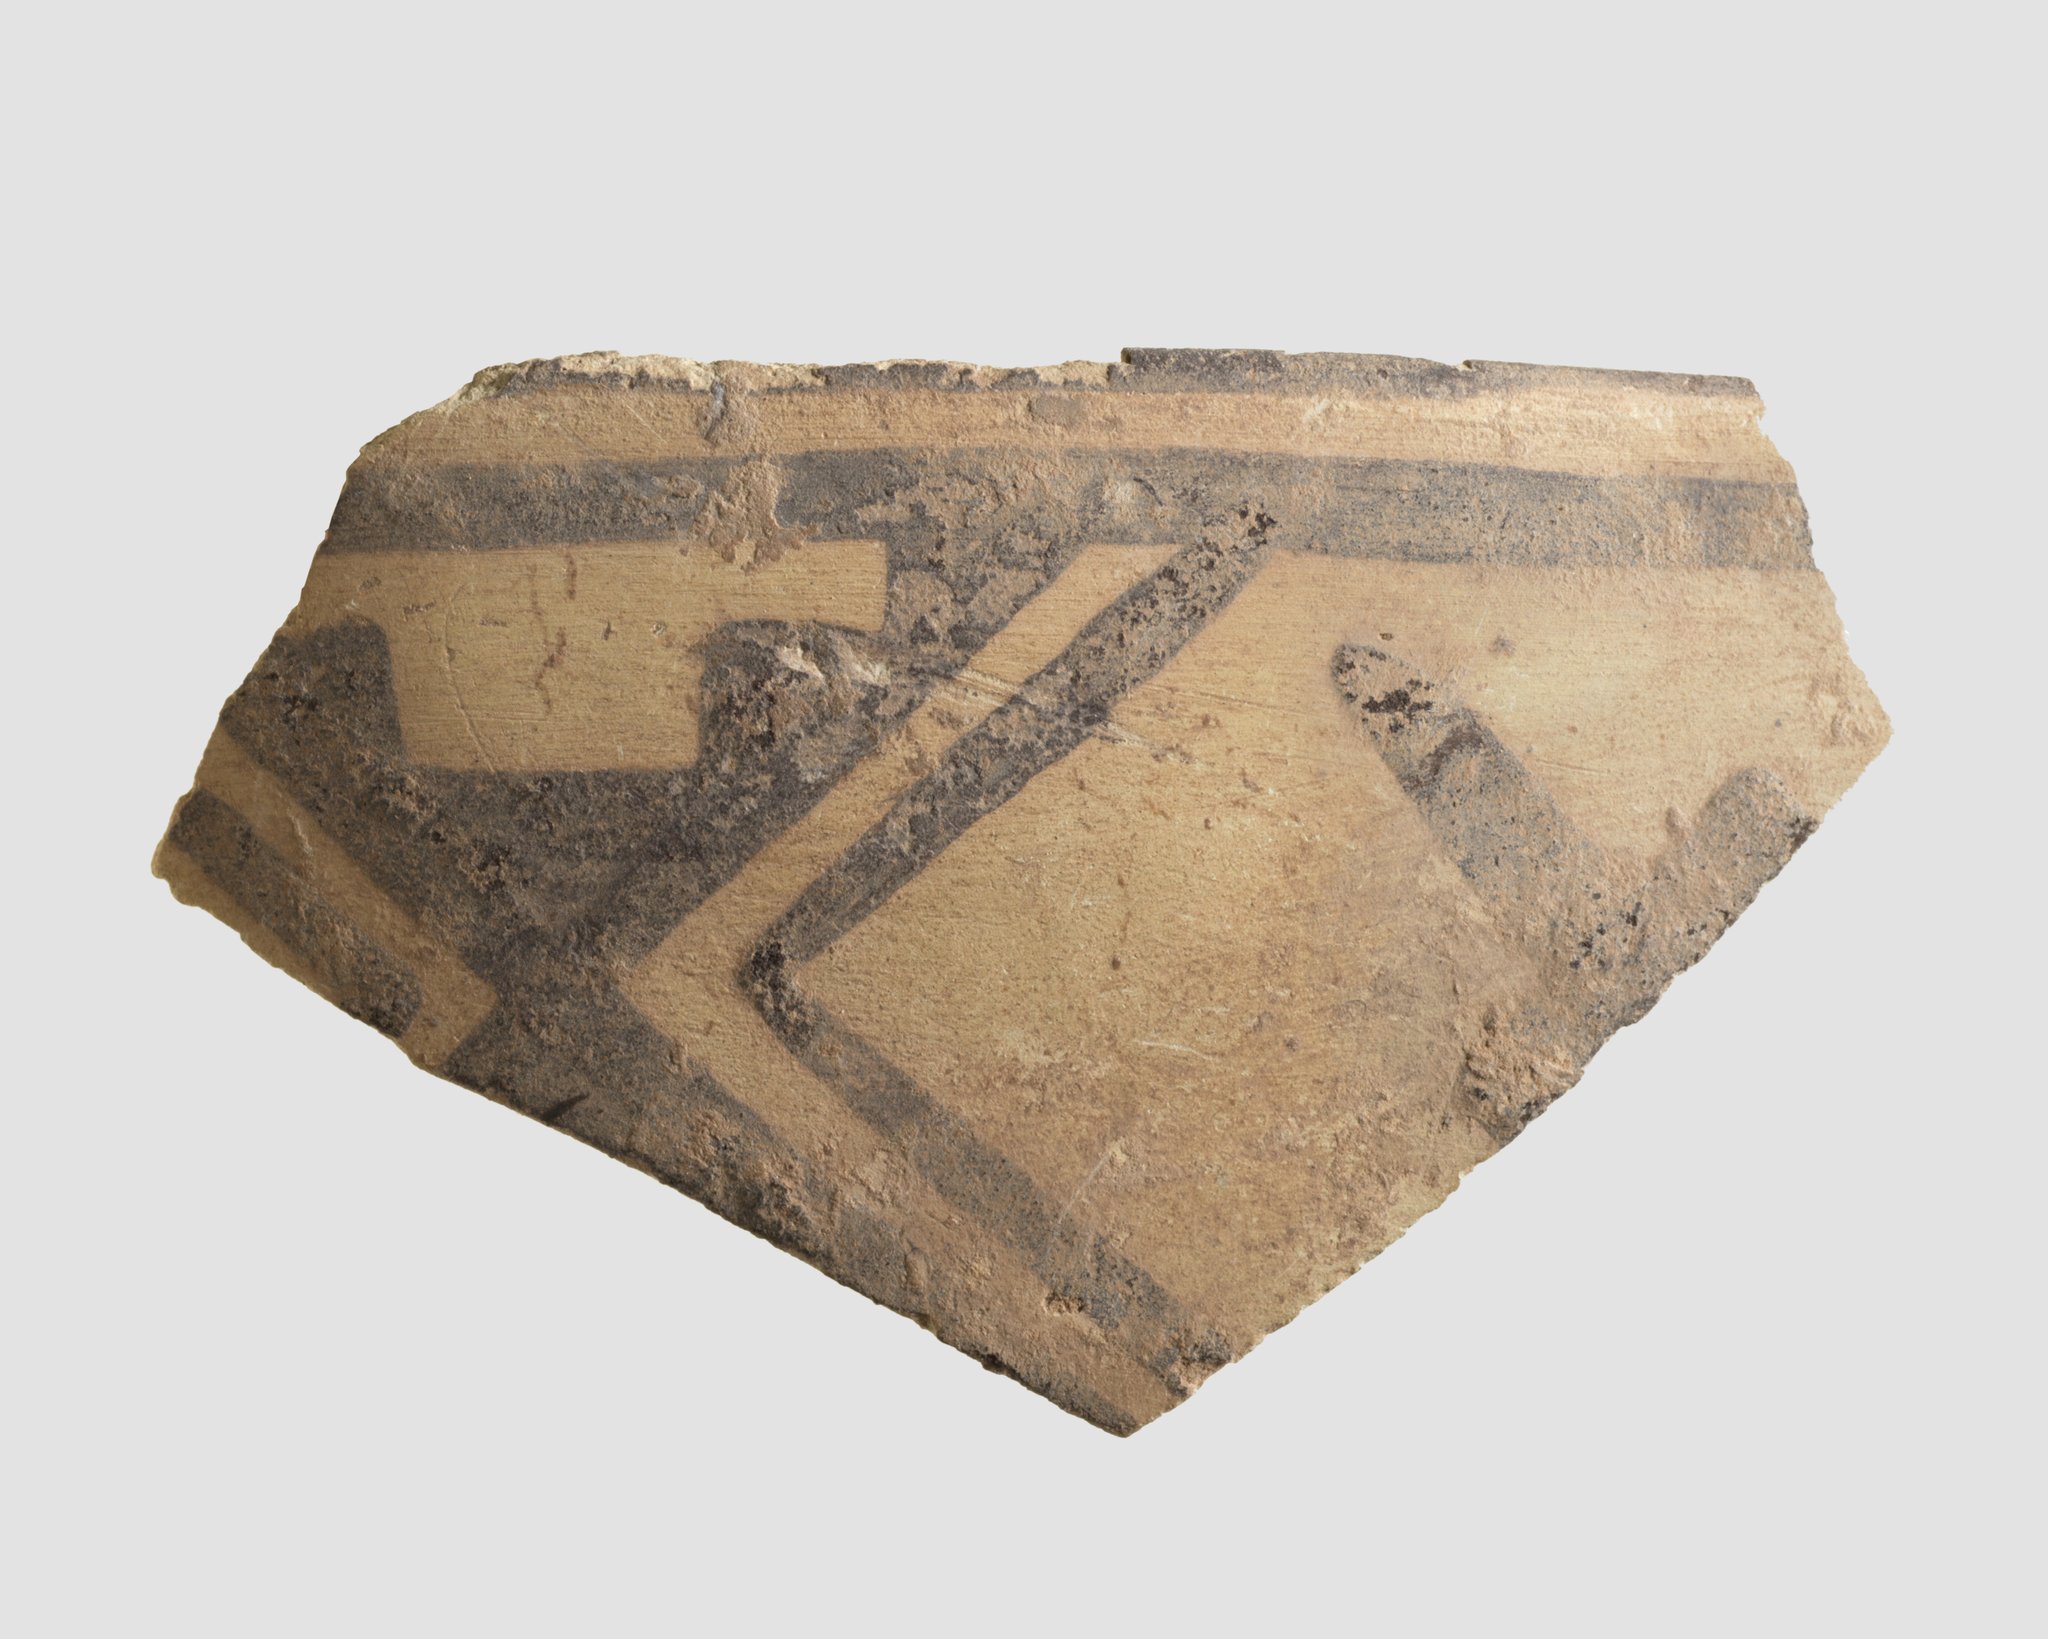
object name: sherd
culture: iranian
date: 2700-2500 BCE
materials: ceramic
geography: iran